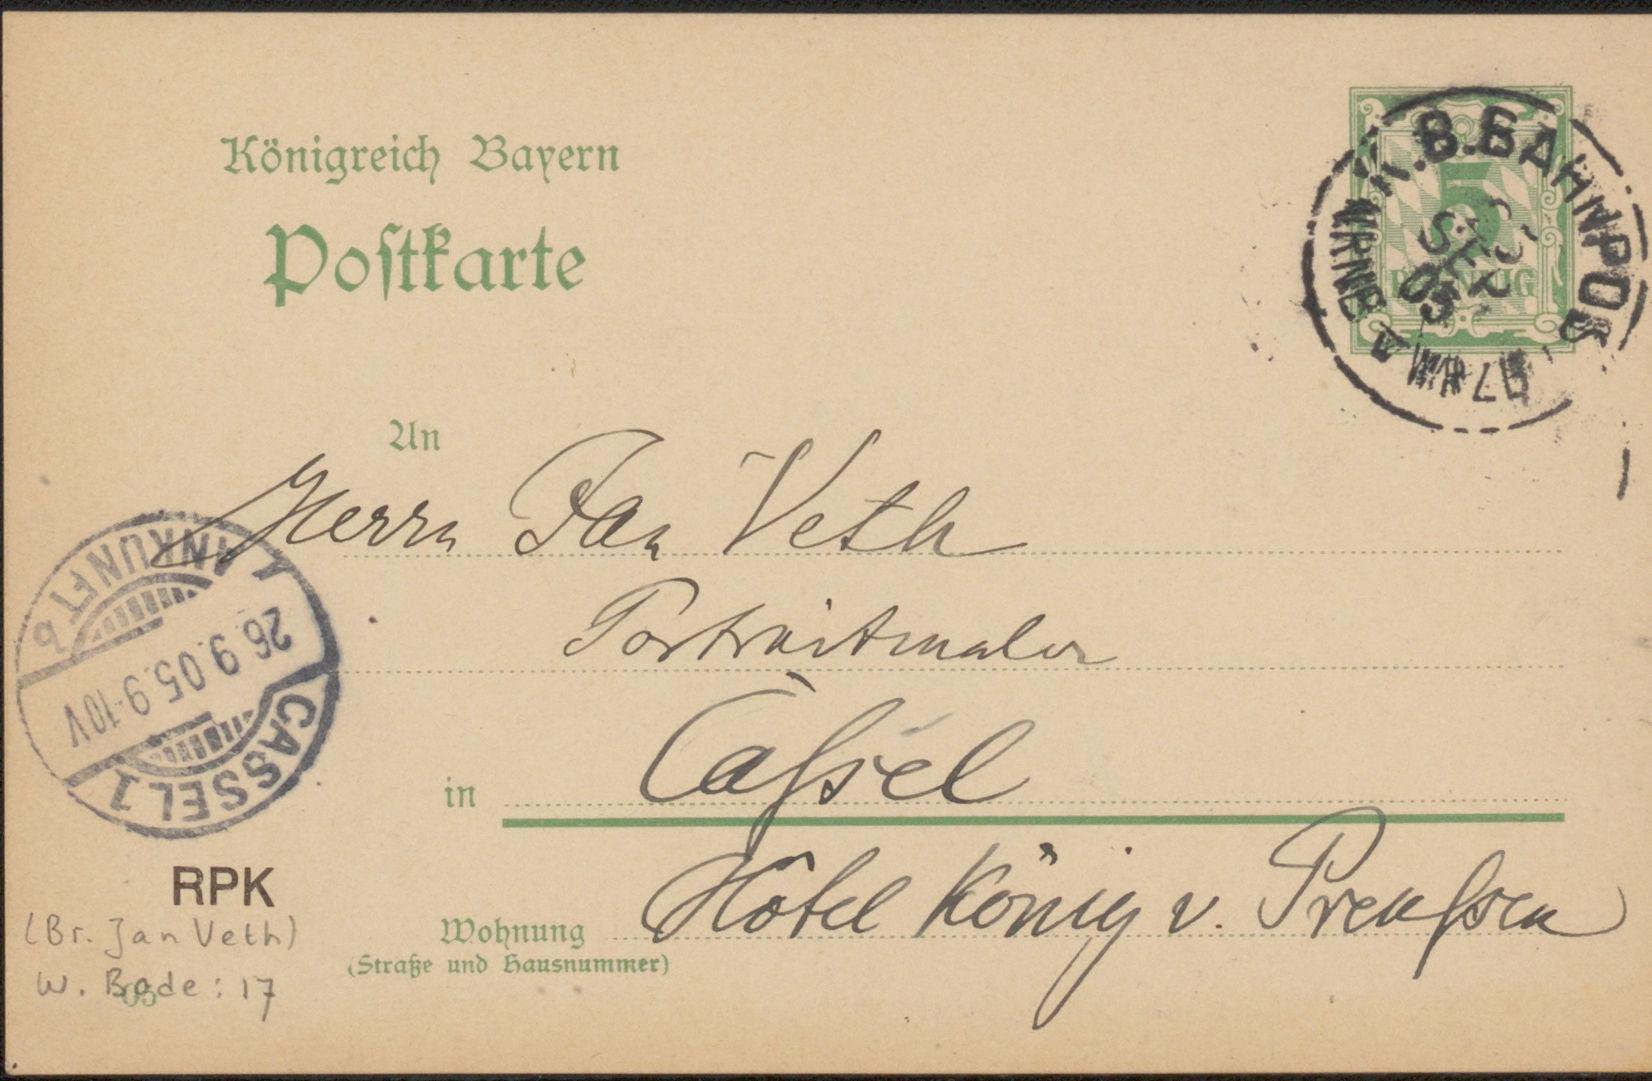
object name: postcard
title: Briefkaart aan Jan Veth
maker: wilhelm von bode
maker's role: conservator, kunsthistoricus, museumdirecteur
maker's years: 1845-1929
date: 1905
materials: cardboard, ink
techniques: pen, writing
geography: nuremberg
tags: dordrecht, painter, print maker, draughtsman, designer, jan veth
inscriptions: collector's mark: ‘RPK’